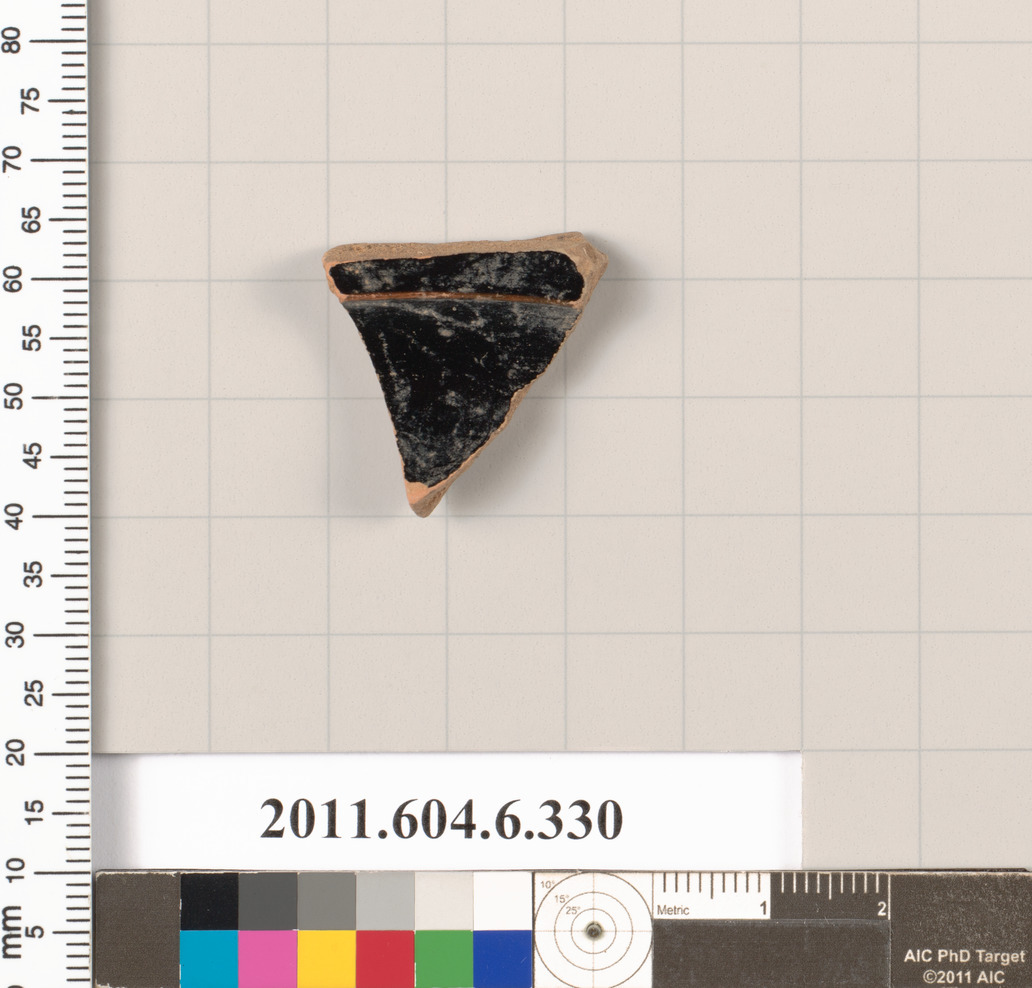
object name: open shape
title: Terracotta fragment of an open shape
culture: greek, attic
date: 600-401 BCE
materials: terracotta